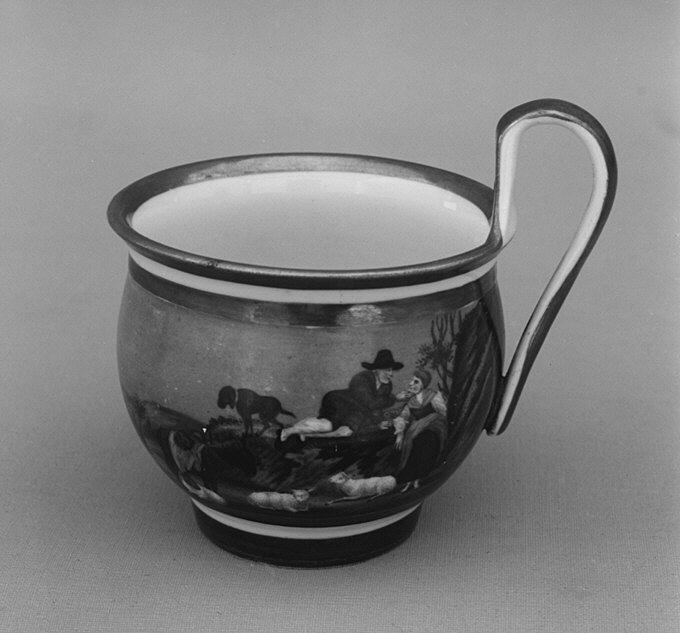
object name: cup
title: Cup (one of six) (part of a set)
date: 1820-1830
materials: hard paste porcelain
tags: human figures,animals